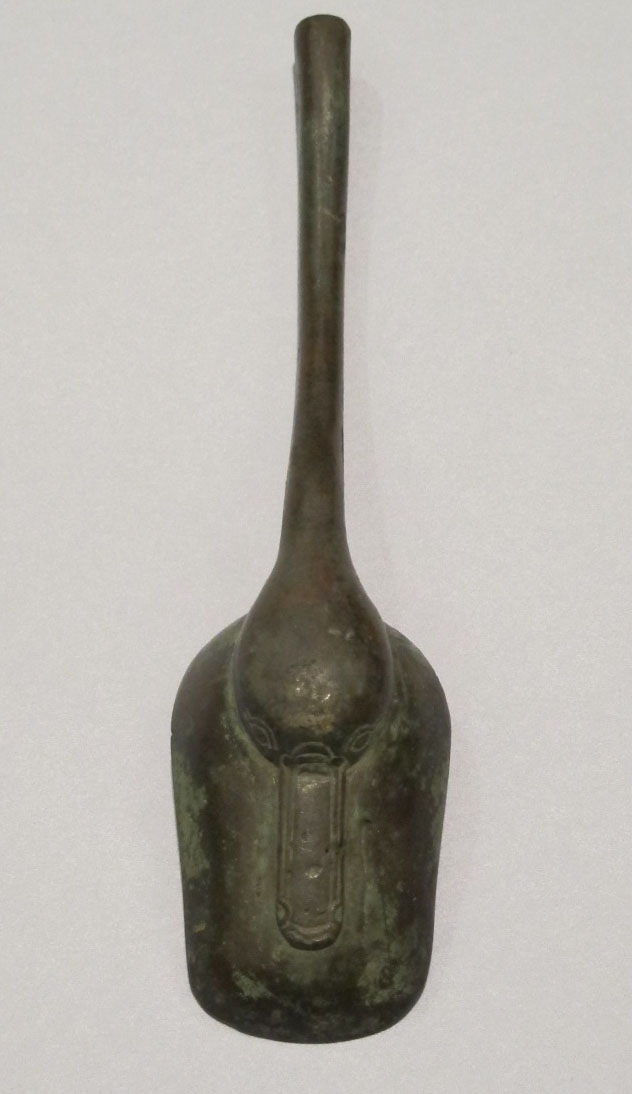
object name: spoon, duck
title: Spoon Decorated with a Duck's Head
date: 1550-1295 BCE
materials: bronze, copper alloy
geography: egypt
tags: ducks